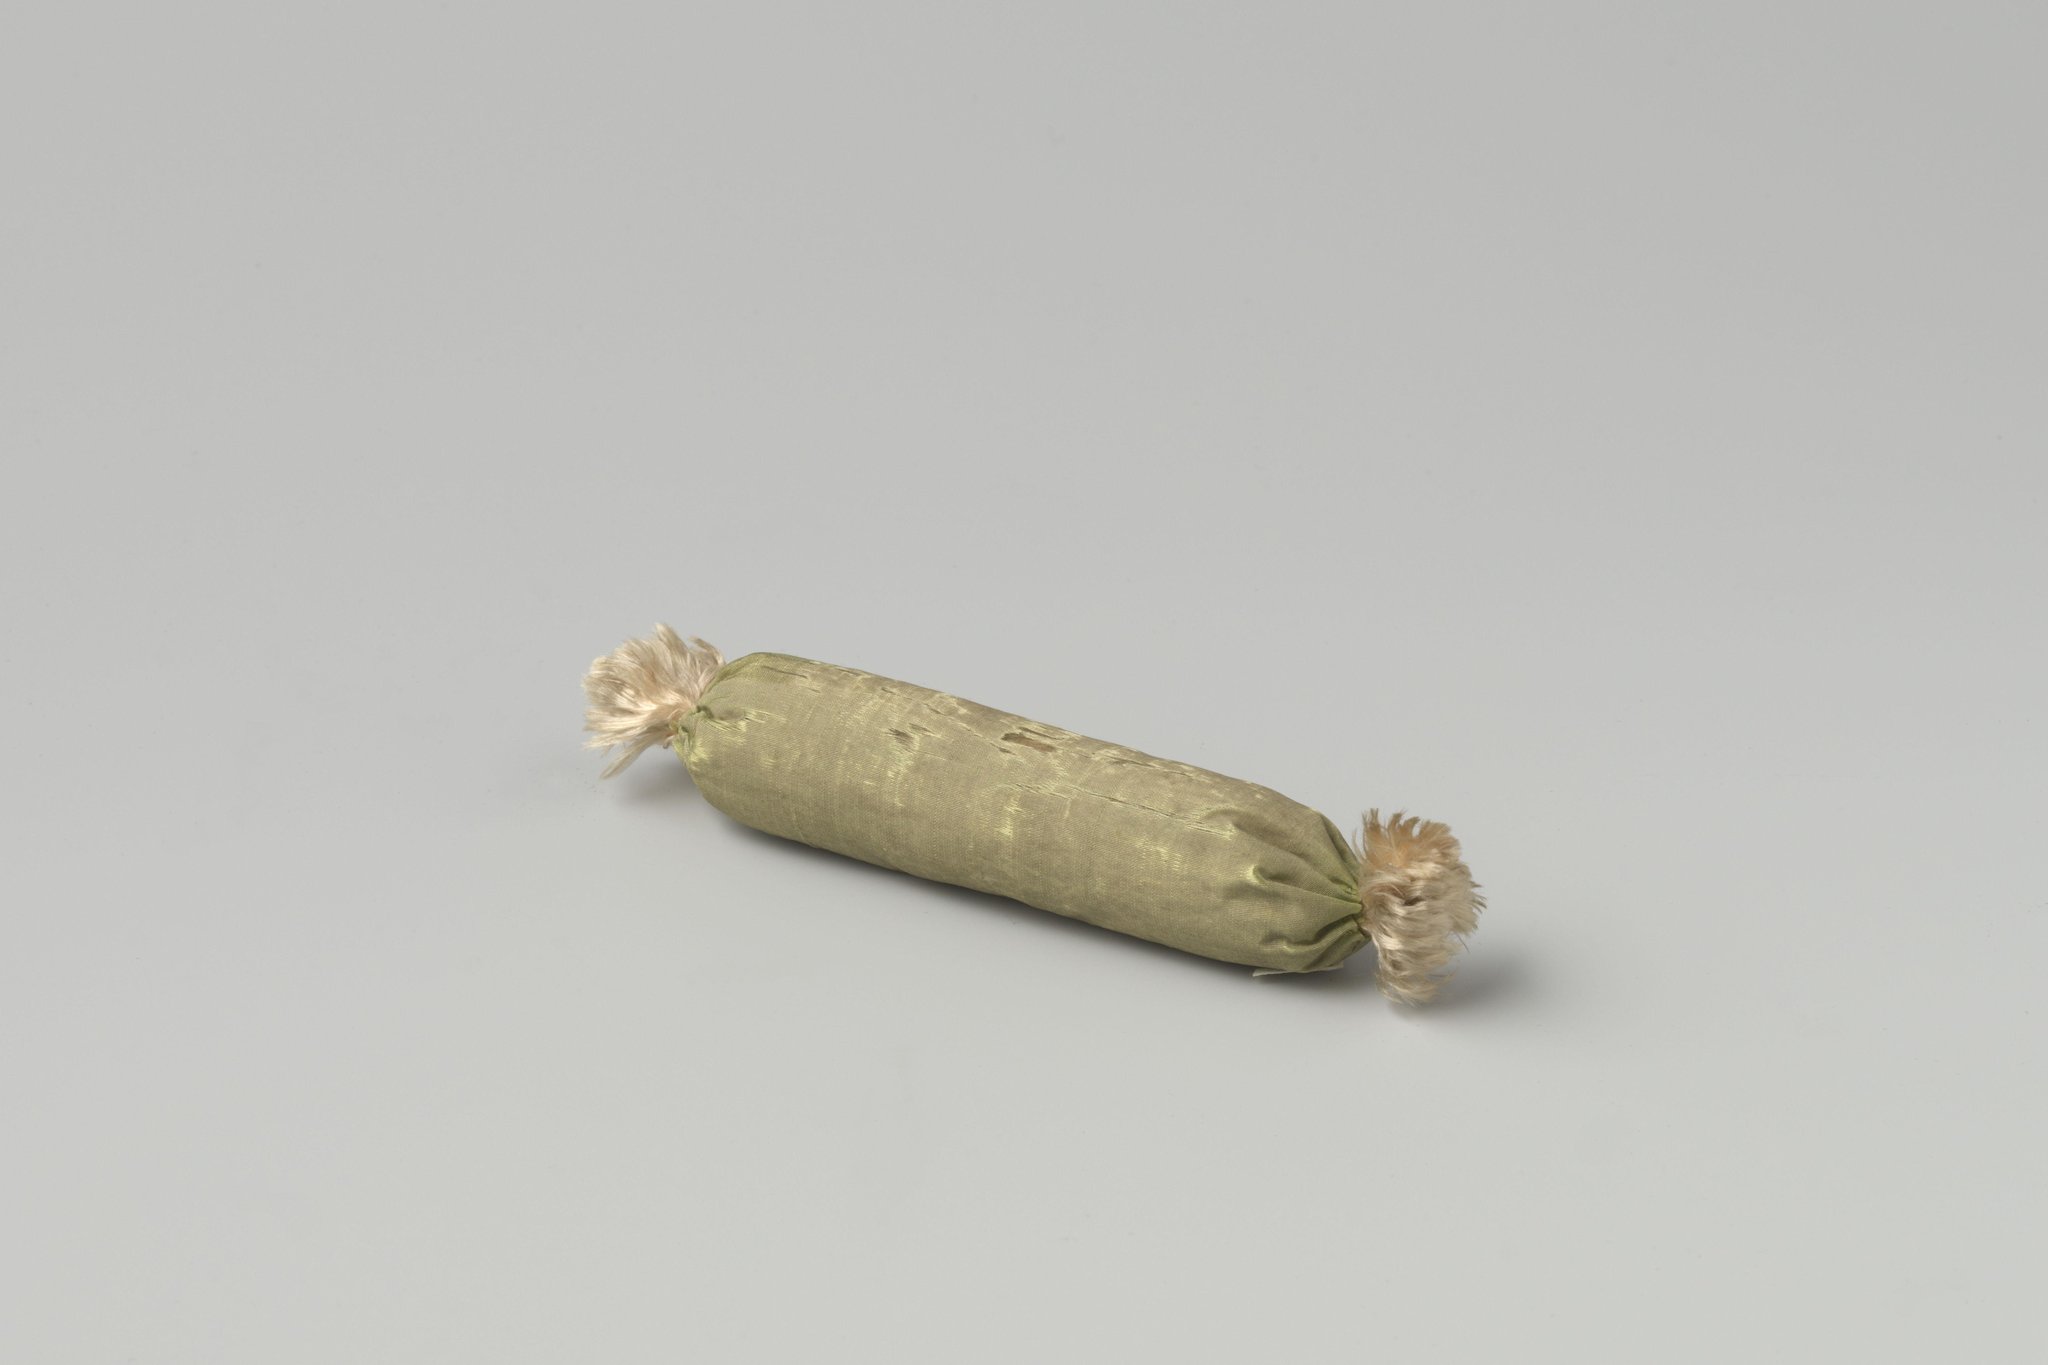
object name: miniature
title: Rolkussen, vervaardigd van zacht groene zijde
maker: Anonymous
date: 1690-1710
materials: down, silk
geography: amsterdam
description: Rolkussen, vervaardigd van zachtgroene zijde, gevuld met bruine dons; aan weerszijden versierd met wit zijden kwasten, die zijn vastgestikt in de ingerimpelde uiteinden van de rol.